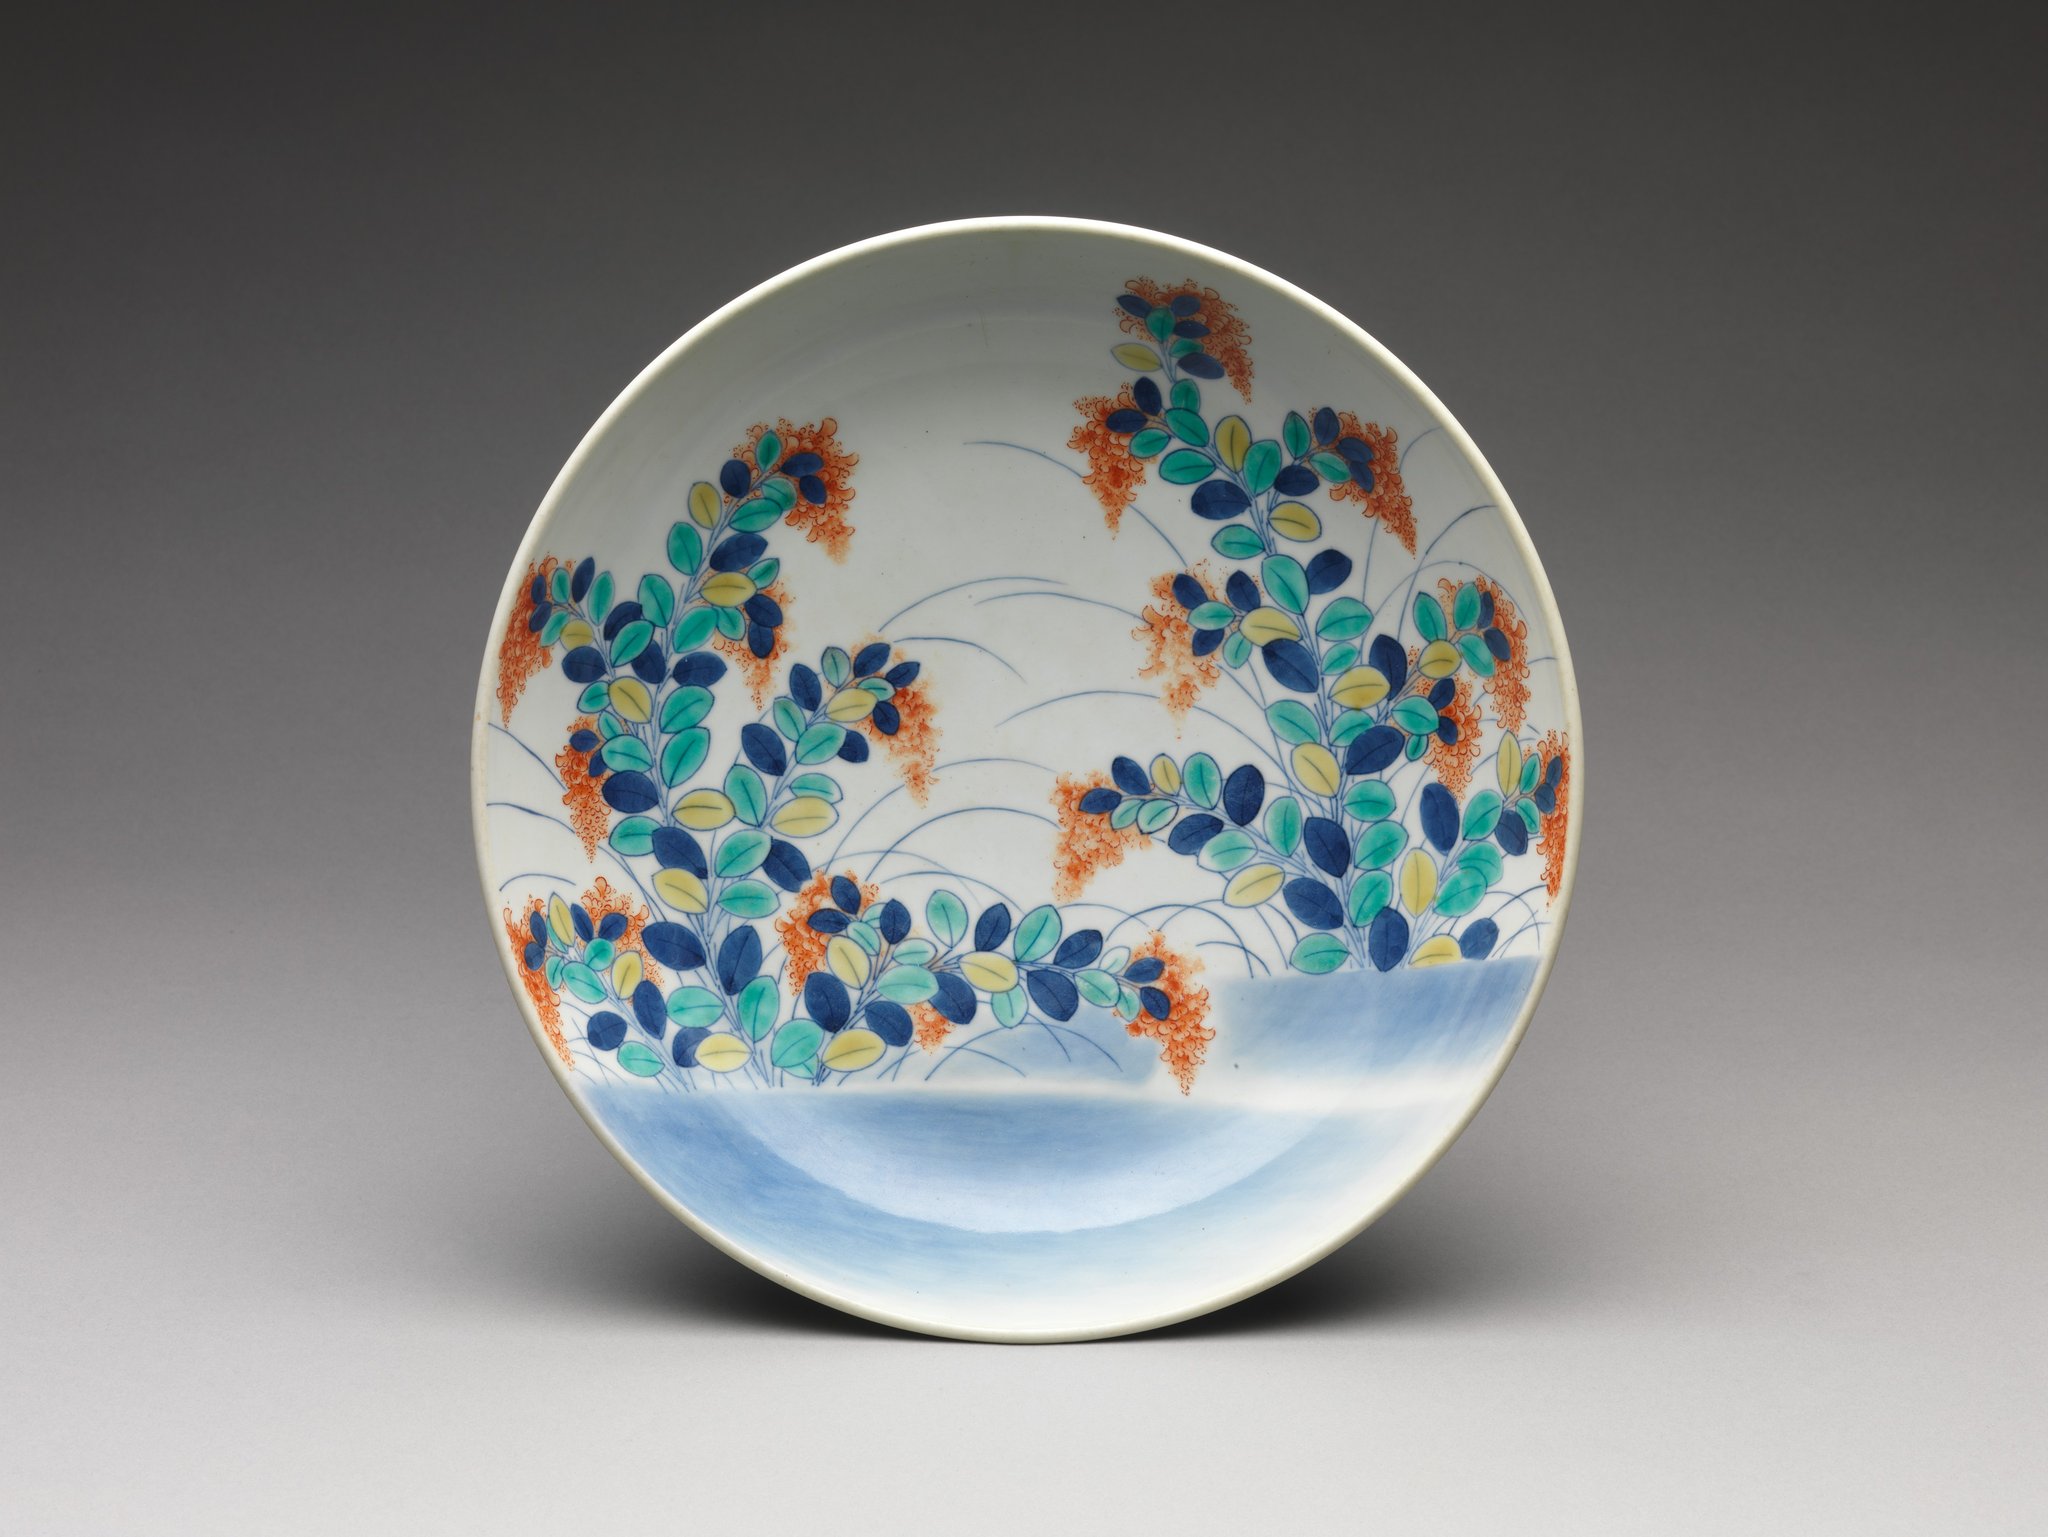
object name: dish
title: Dish with Bush Clover Design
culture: japanese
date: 1701-1800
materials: enamel, porcelain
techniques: overglaze, painting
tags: leaves